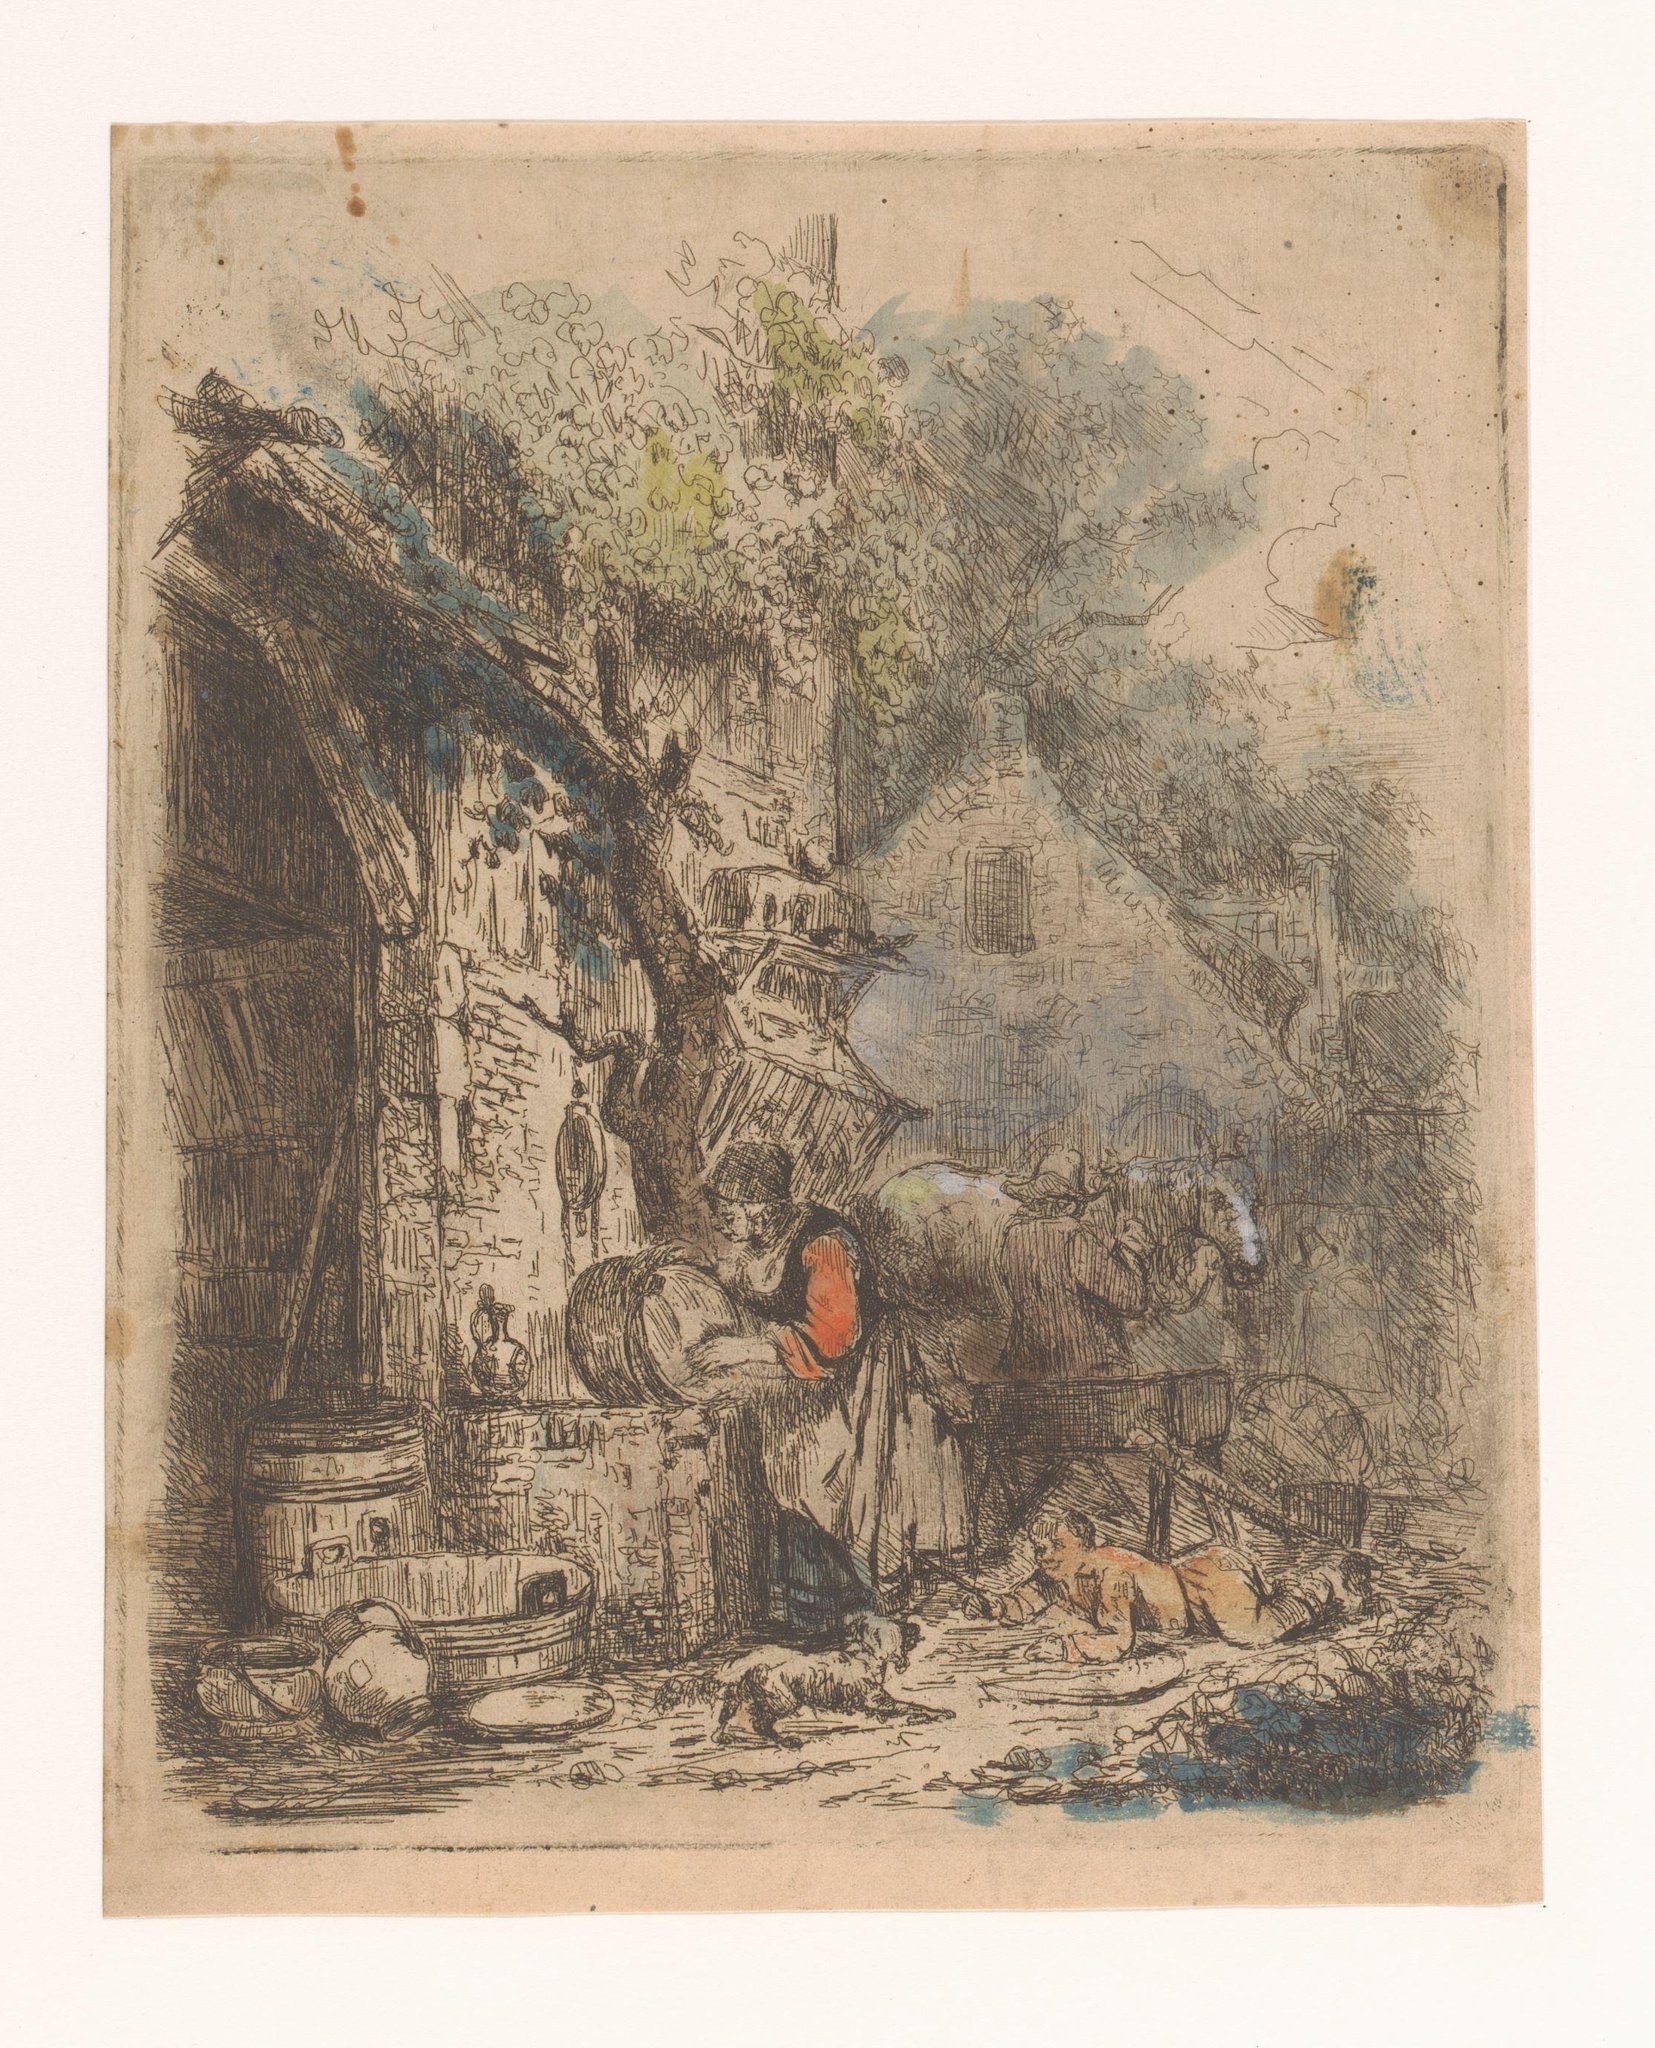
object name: print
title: Straatgezicht met vrouw die een ketel schuurt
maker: adrien joseph verhoeven-ball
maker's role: draughtsman, print maker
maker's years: 1824-1882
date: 1847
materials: paper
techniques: drypoint, etching, hand coloring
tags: kitchen-utensils (with name), street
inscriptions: collector's mark: Lugt 2228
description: Gezicht op een steeg achter een huis met een vrouw die een ketel schuurt. Op de grond een liggende jongen die met een hond speelt.